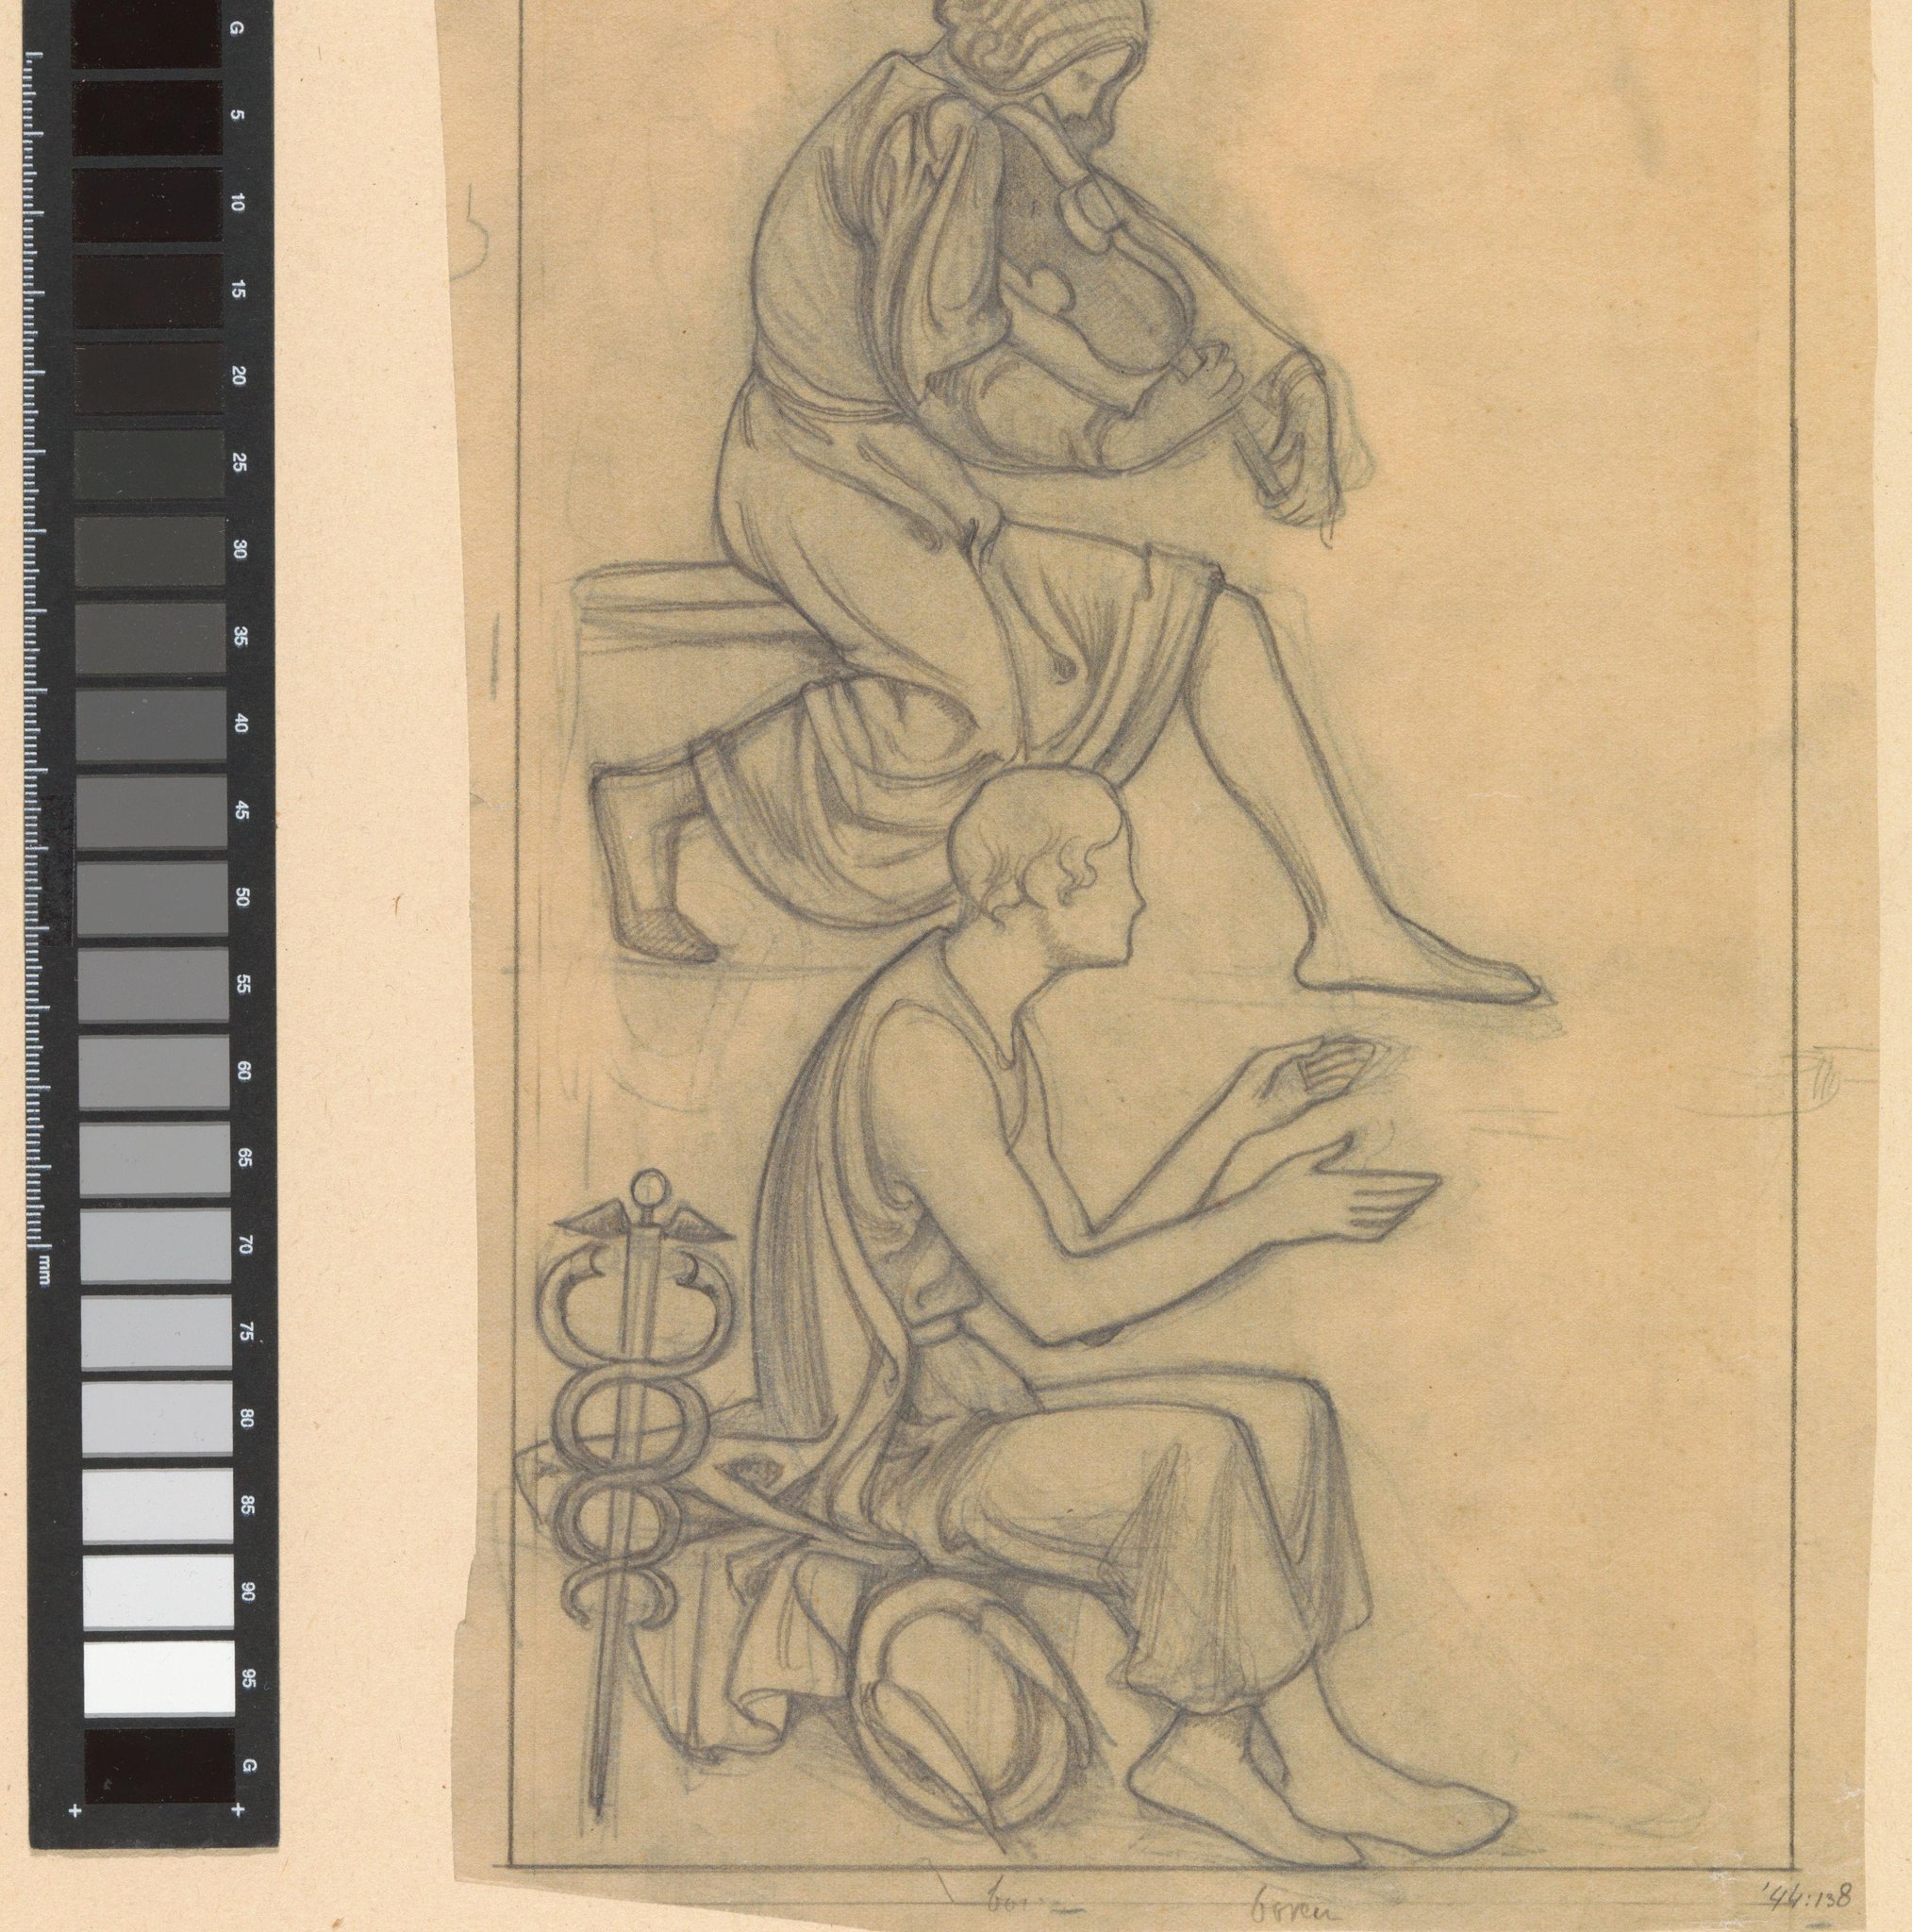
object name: tracing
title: Ontwerp voor wandschildering in de Beurs van Berlage: zittende vioolspeler en Mercurius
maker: antoon derkinderen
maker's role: draughtsman, painter, print maker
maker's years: 1859-1925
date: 1869-1925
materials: pencil, paper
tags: (story of) mercury (hermes), one person playing string instrument (bowed), violin, fiddle